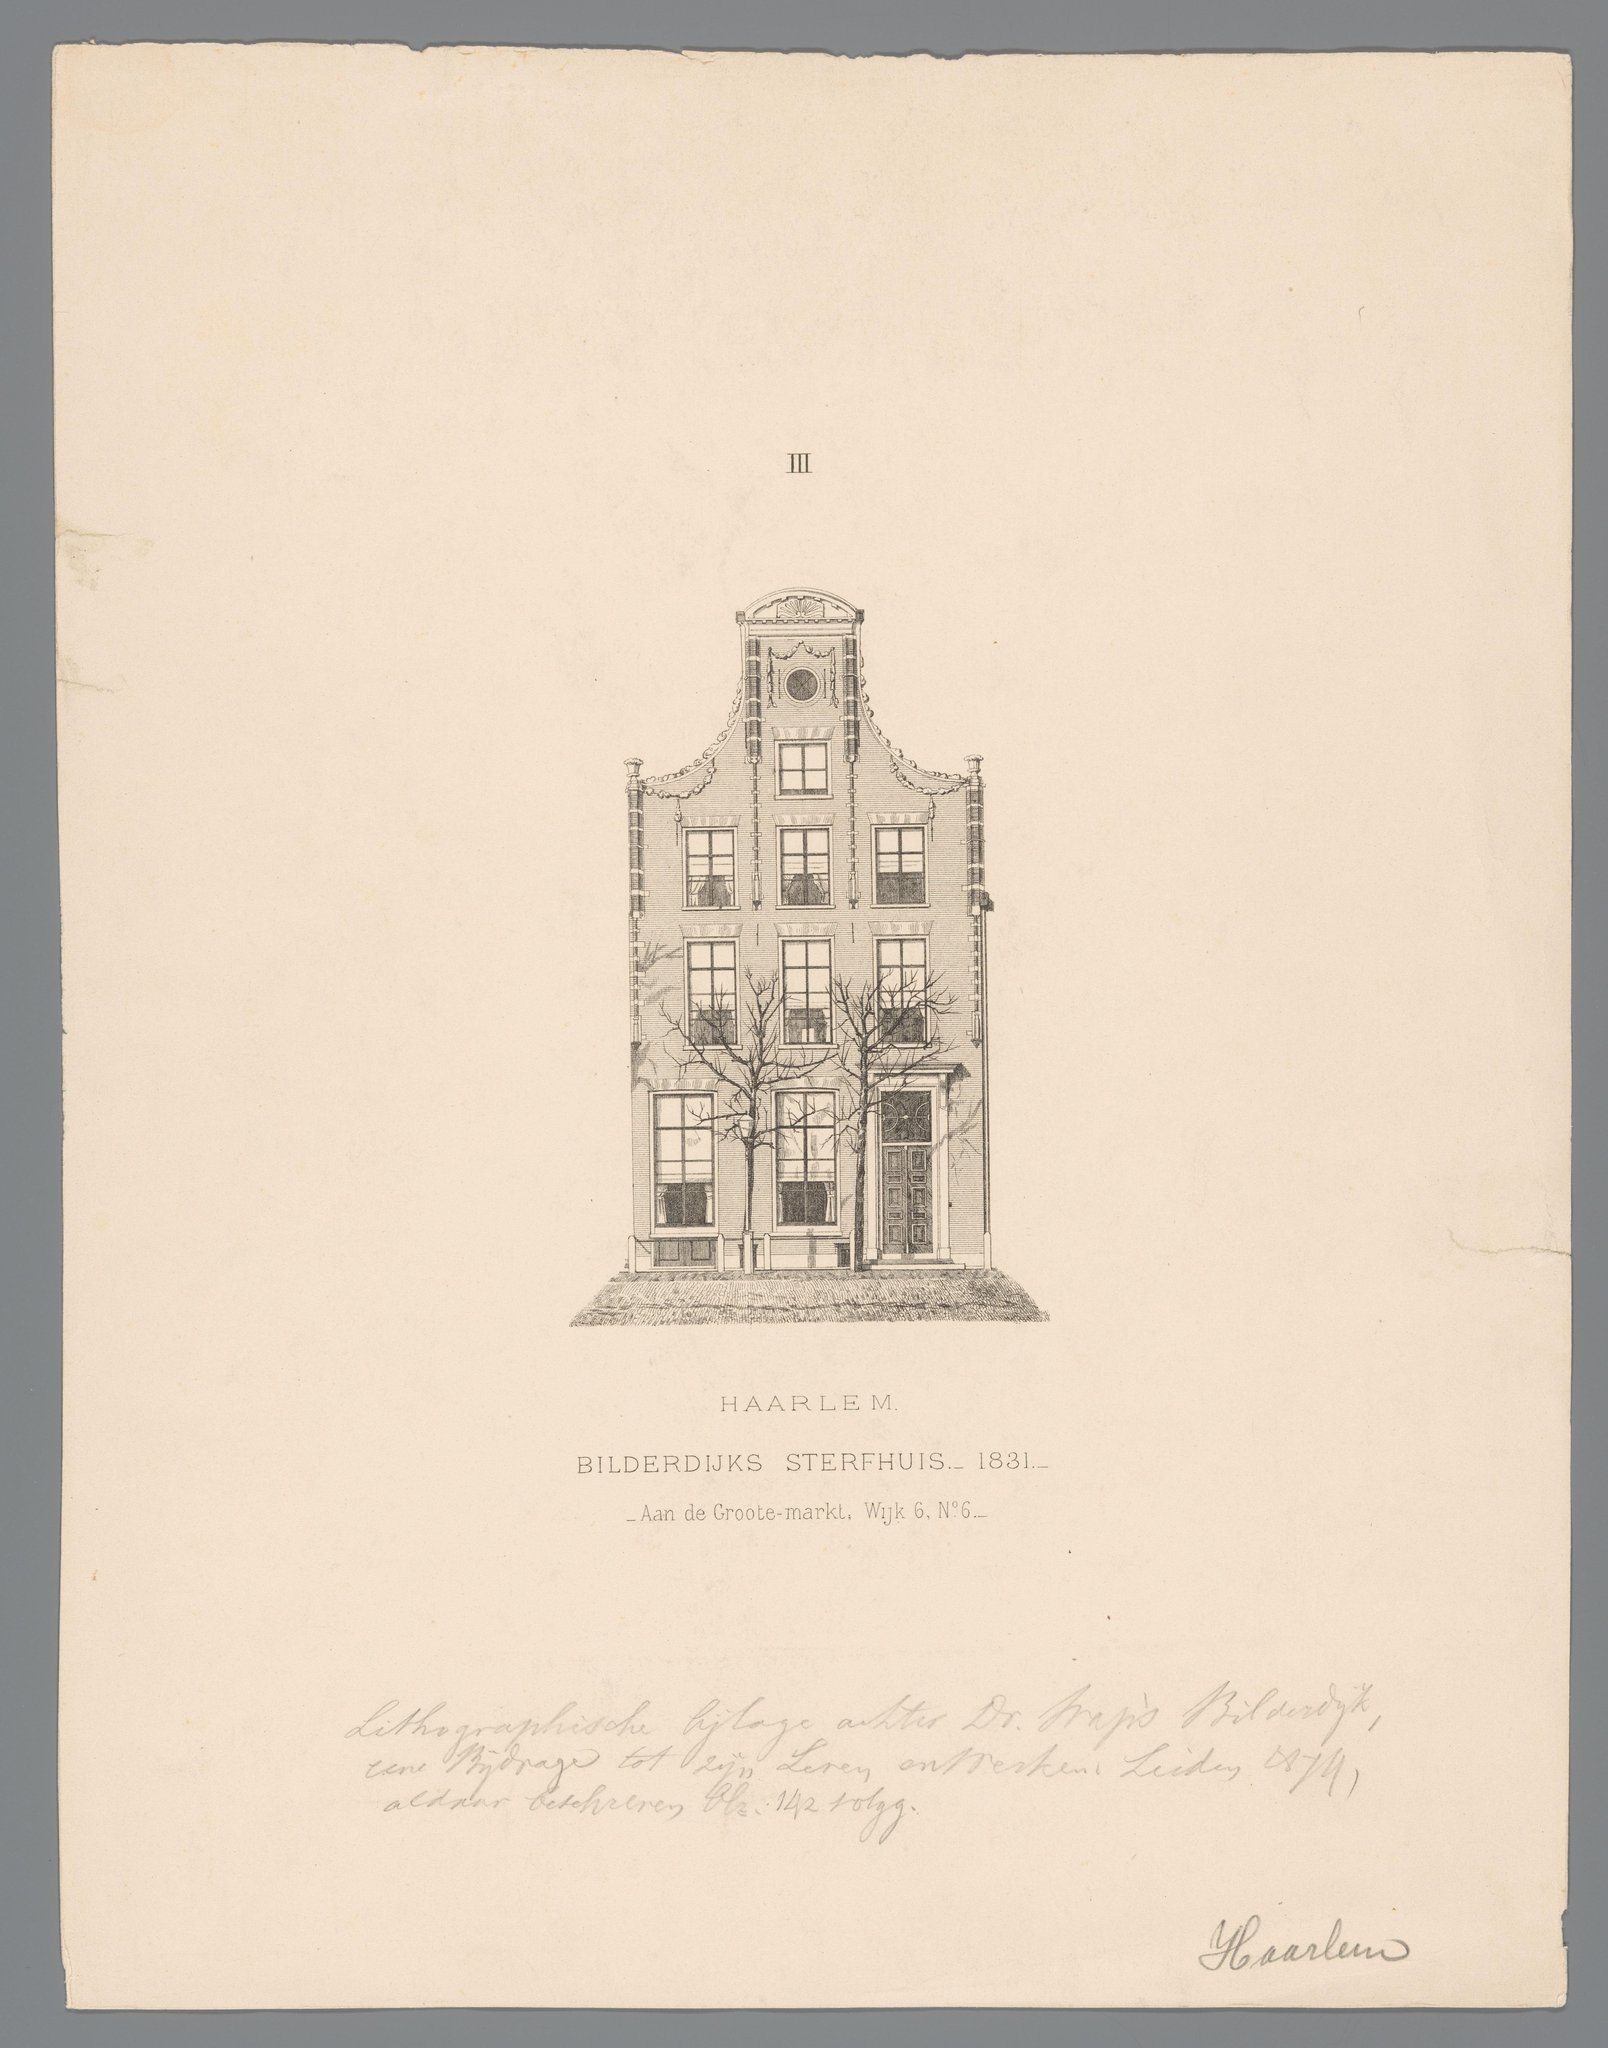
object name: print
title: Gezicht op het huis waar Bilderdijk stierf in Haarlem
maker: Anonymous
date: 1874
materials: paper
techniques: lithograph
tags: civic architecture; edifices; dwellings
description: Prent uit: Wap, Jan J.F. Bilderdijk, eene bijdrage tot zijn leven en werken. Leiden: E.J. Brill, 1874.